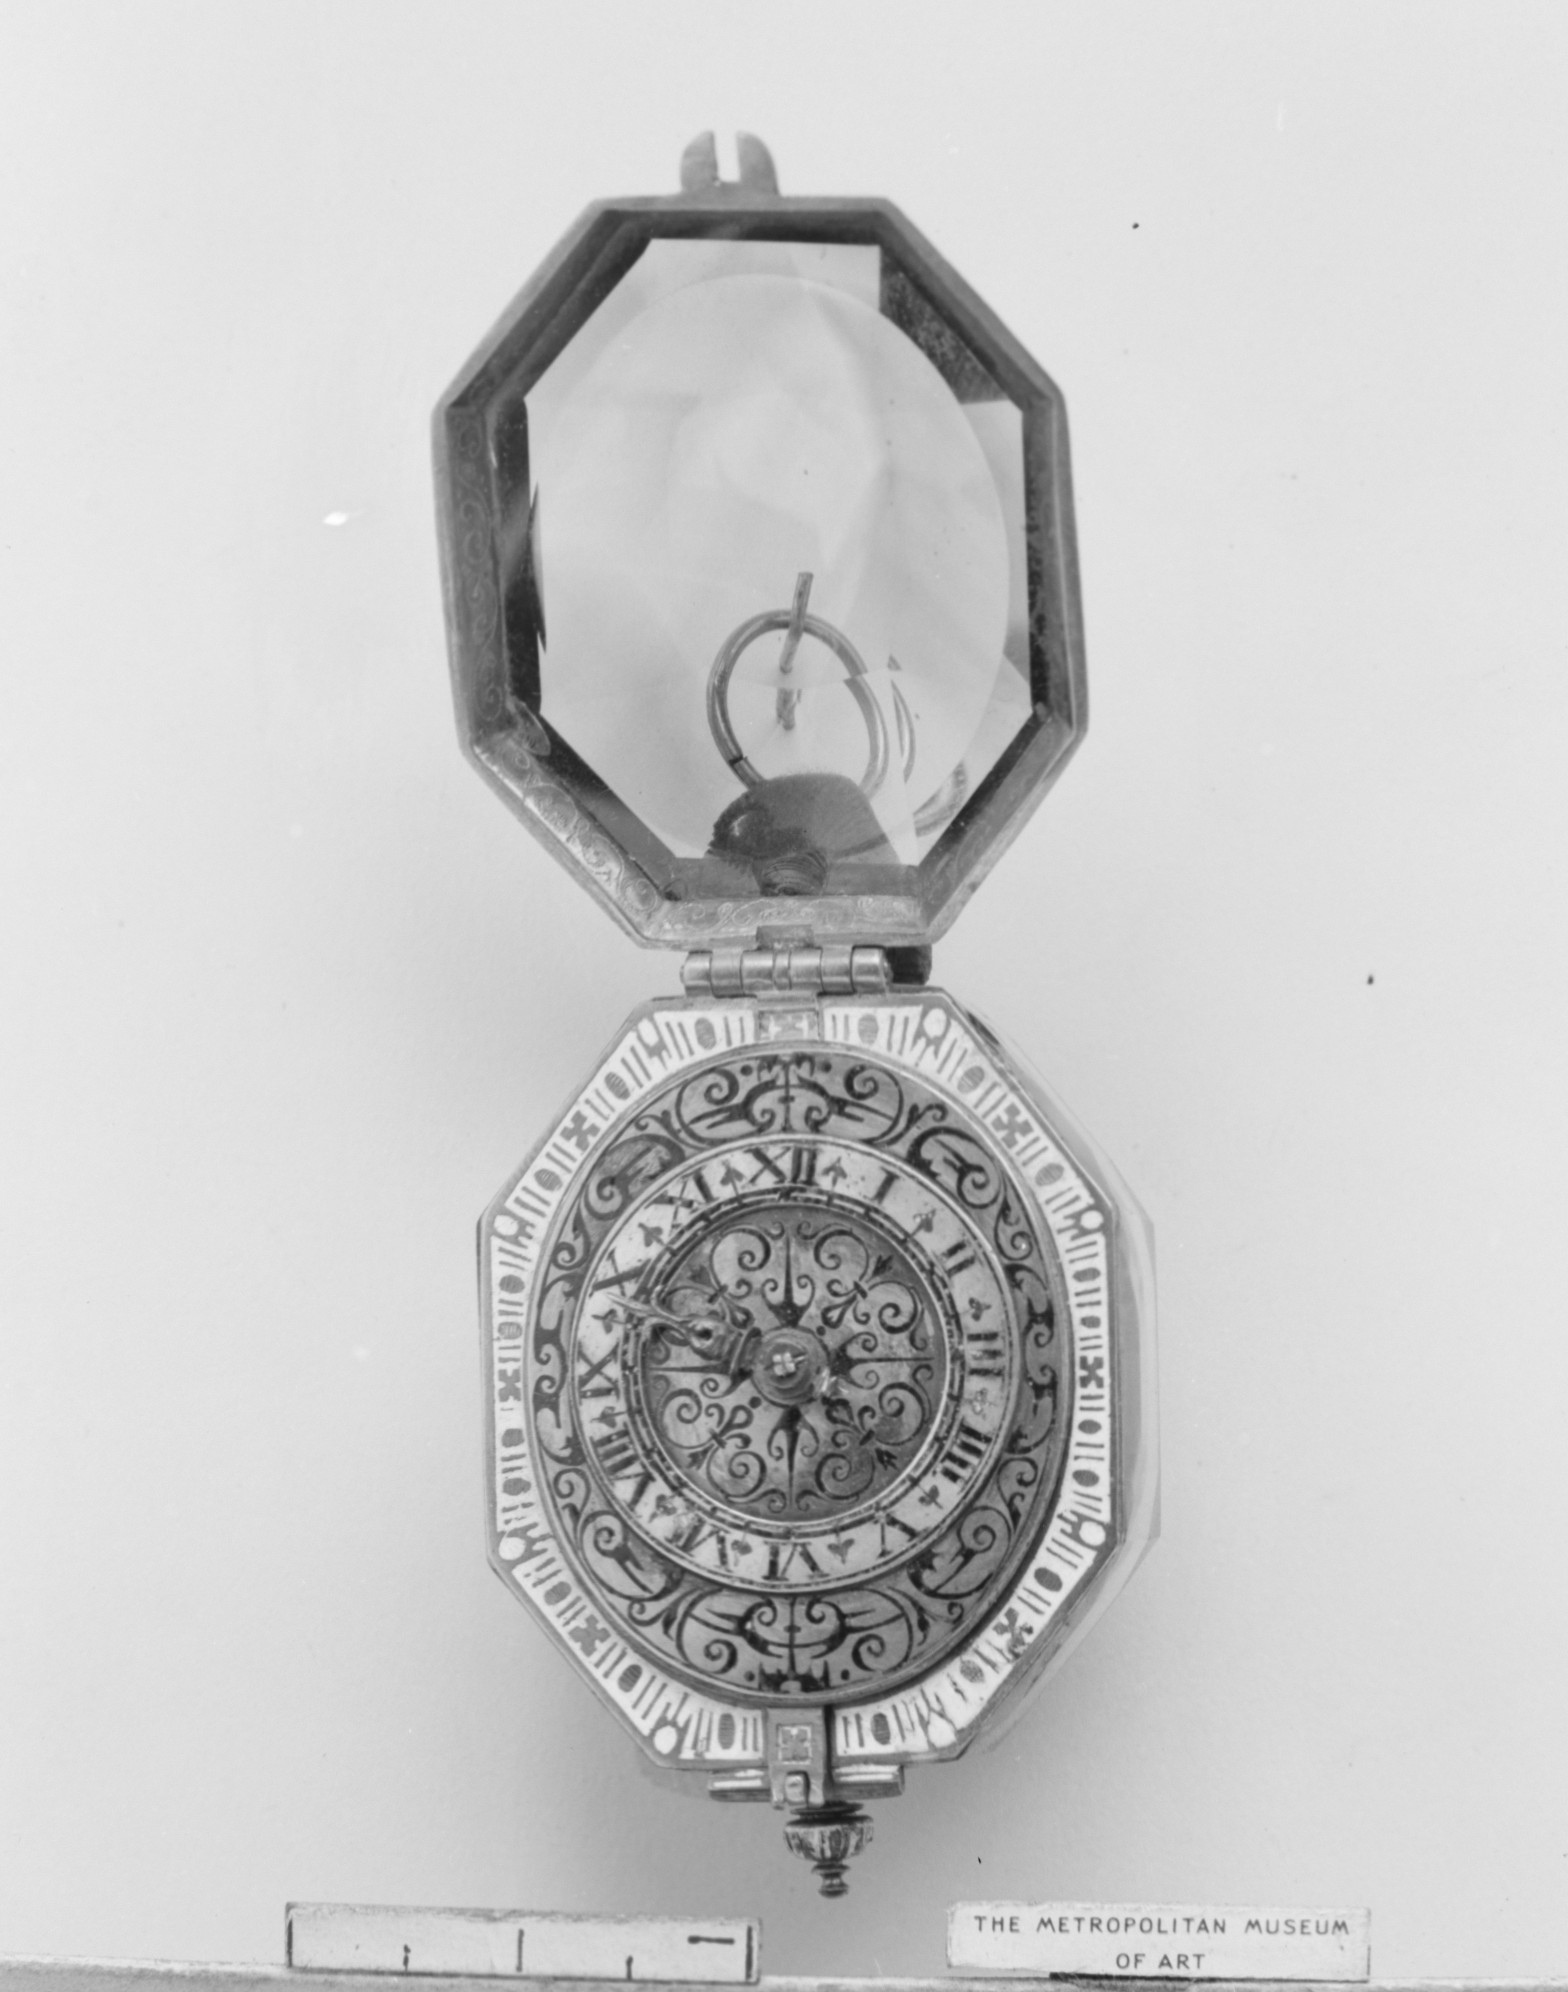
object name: watch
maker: m.k.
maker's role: maker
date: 1650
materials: crystal, gold